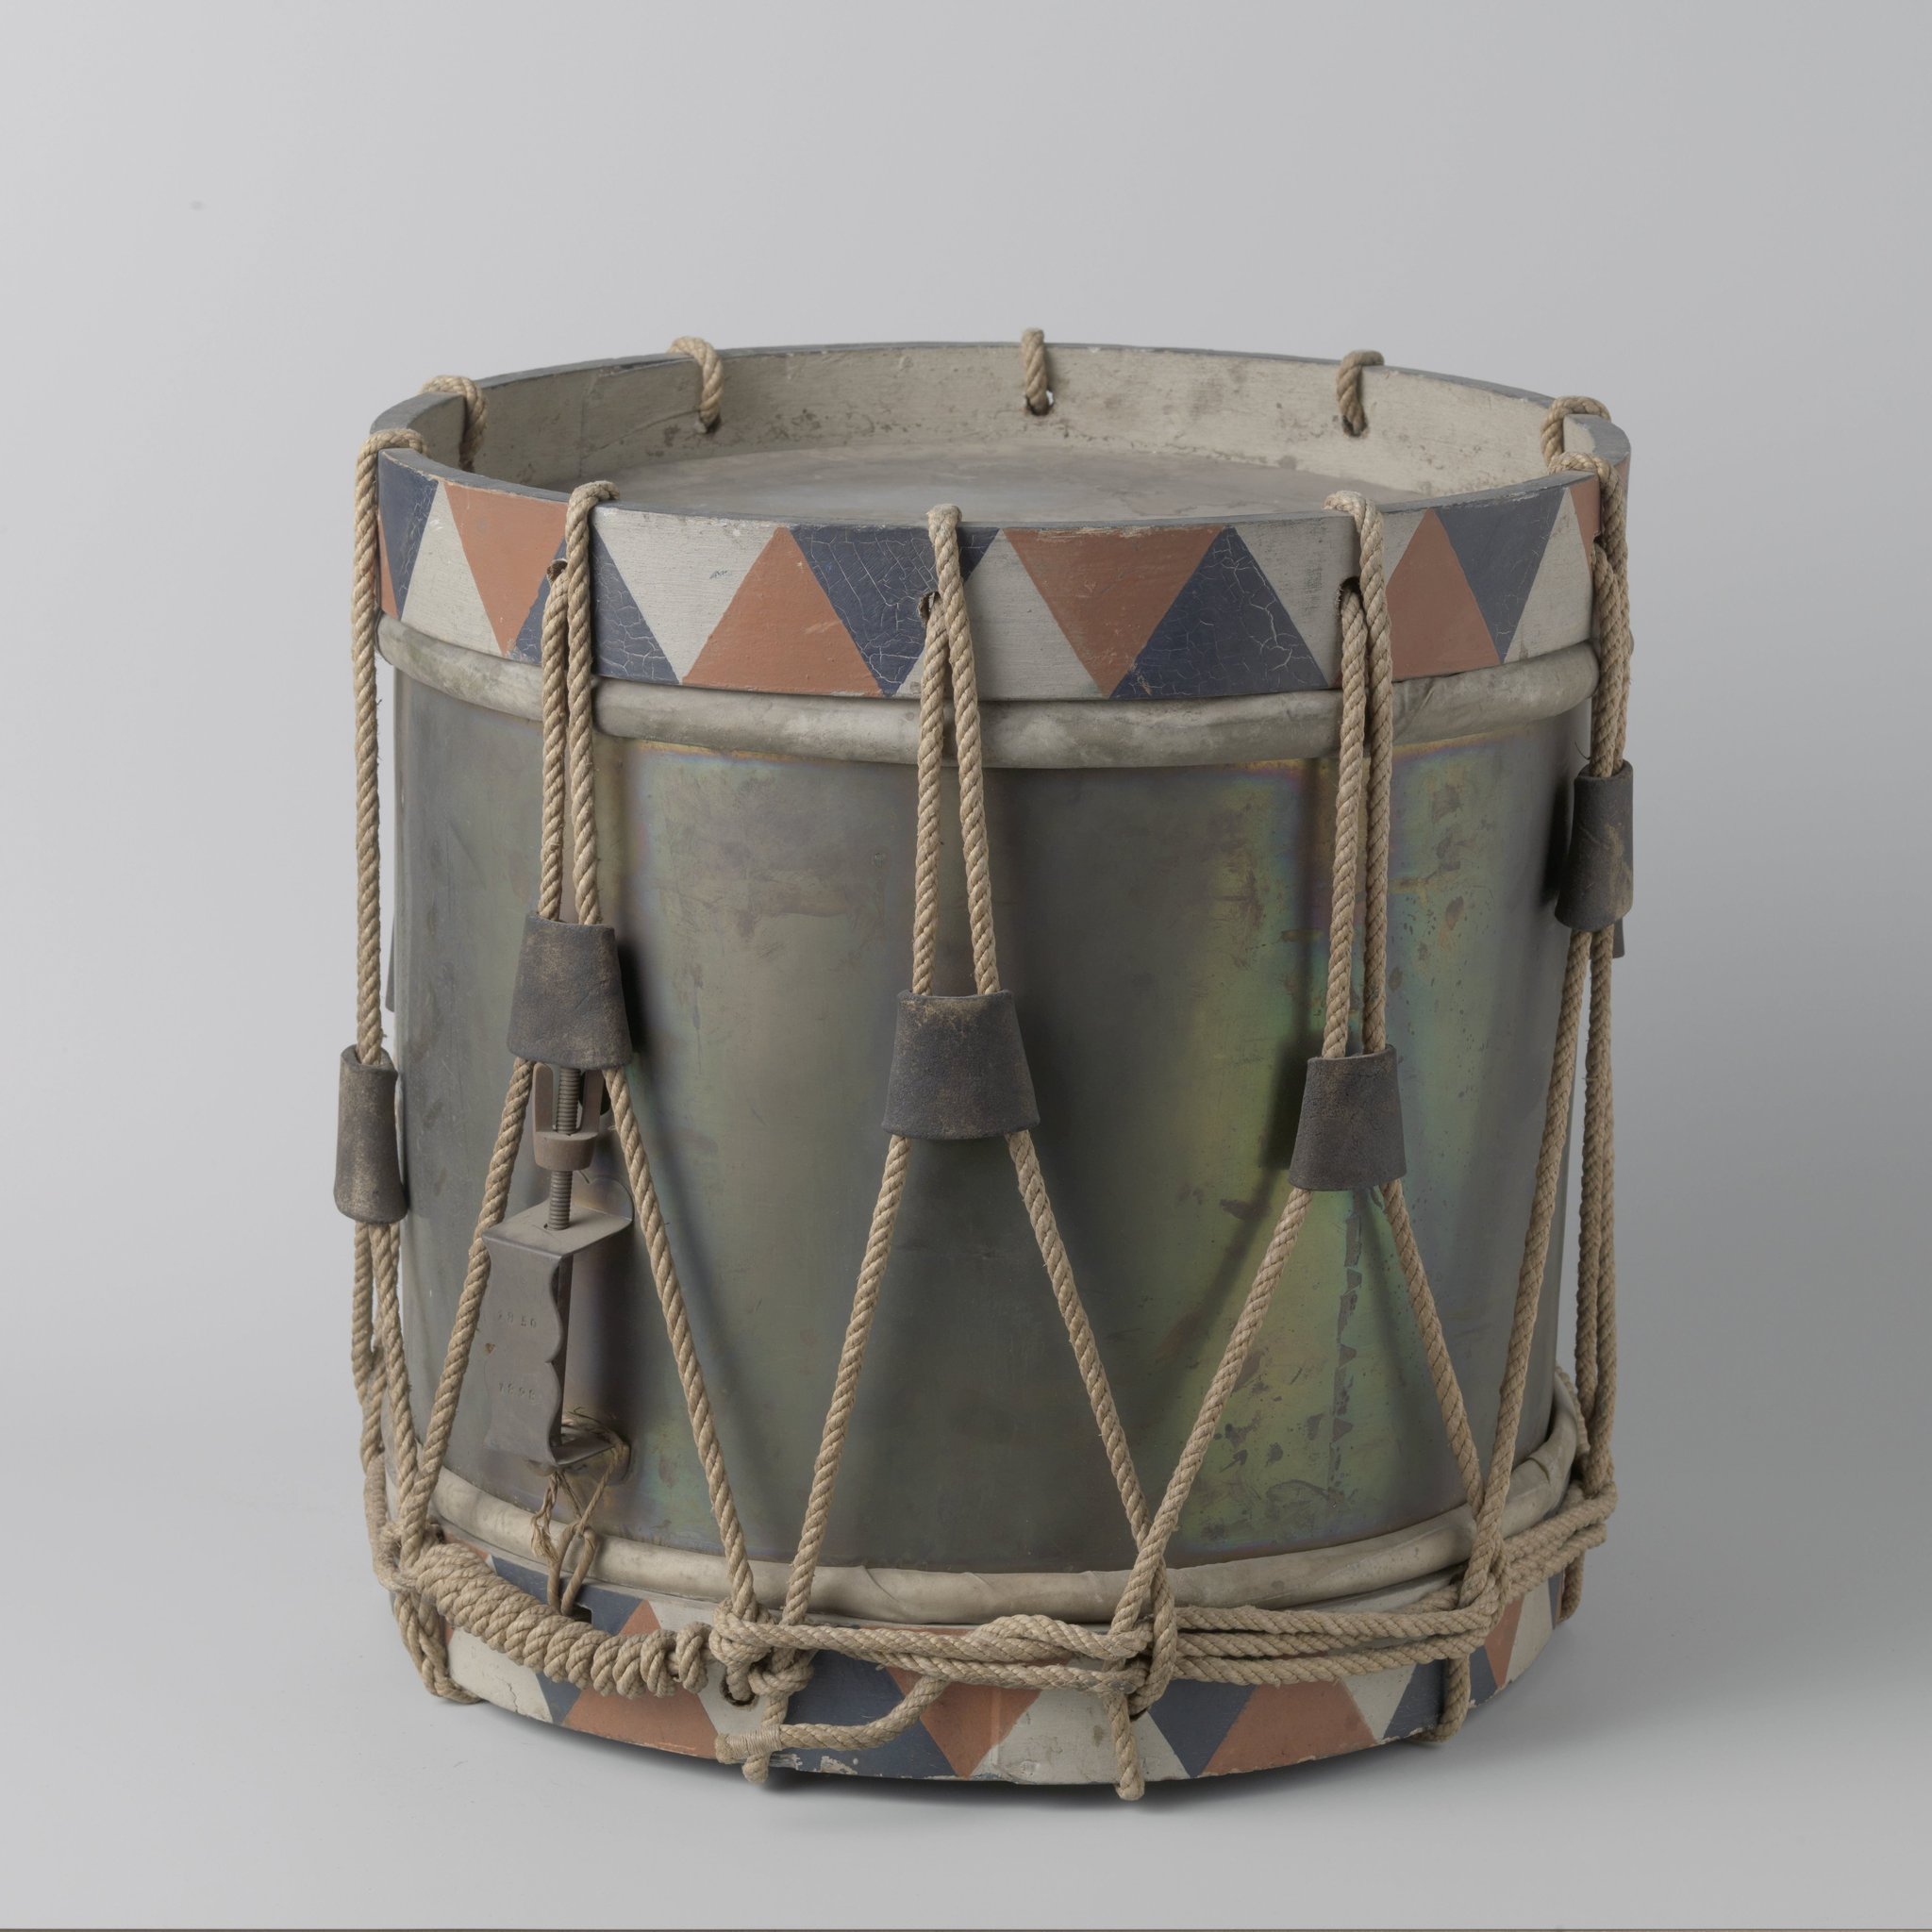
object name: percussion instrument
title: Drum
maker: Anonymous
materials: brass, leather, fiber, wood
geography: netherlands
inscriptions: inscription: ‘1850-1898’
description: Music has always been a crucial element of public celebrations, such as military parades, coronations, royal weddings, and funerals, adding grandeur to the solemnity of the occasion. Musical ensembles entrusted with performing music at these events have existed in Europe since the Middle Ages. This display highlights various marching bands and their musical instruments dating from the 16th to the 19th century.